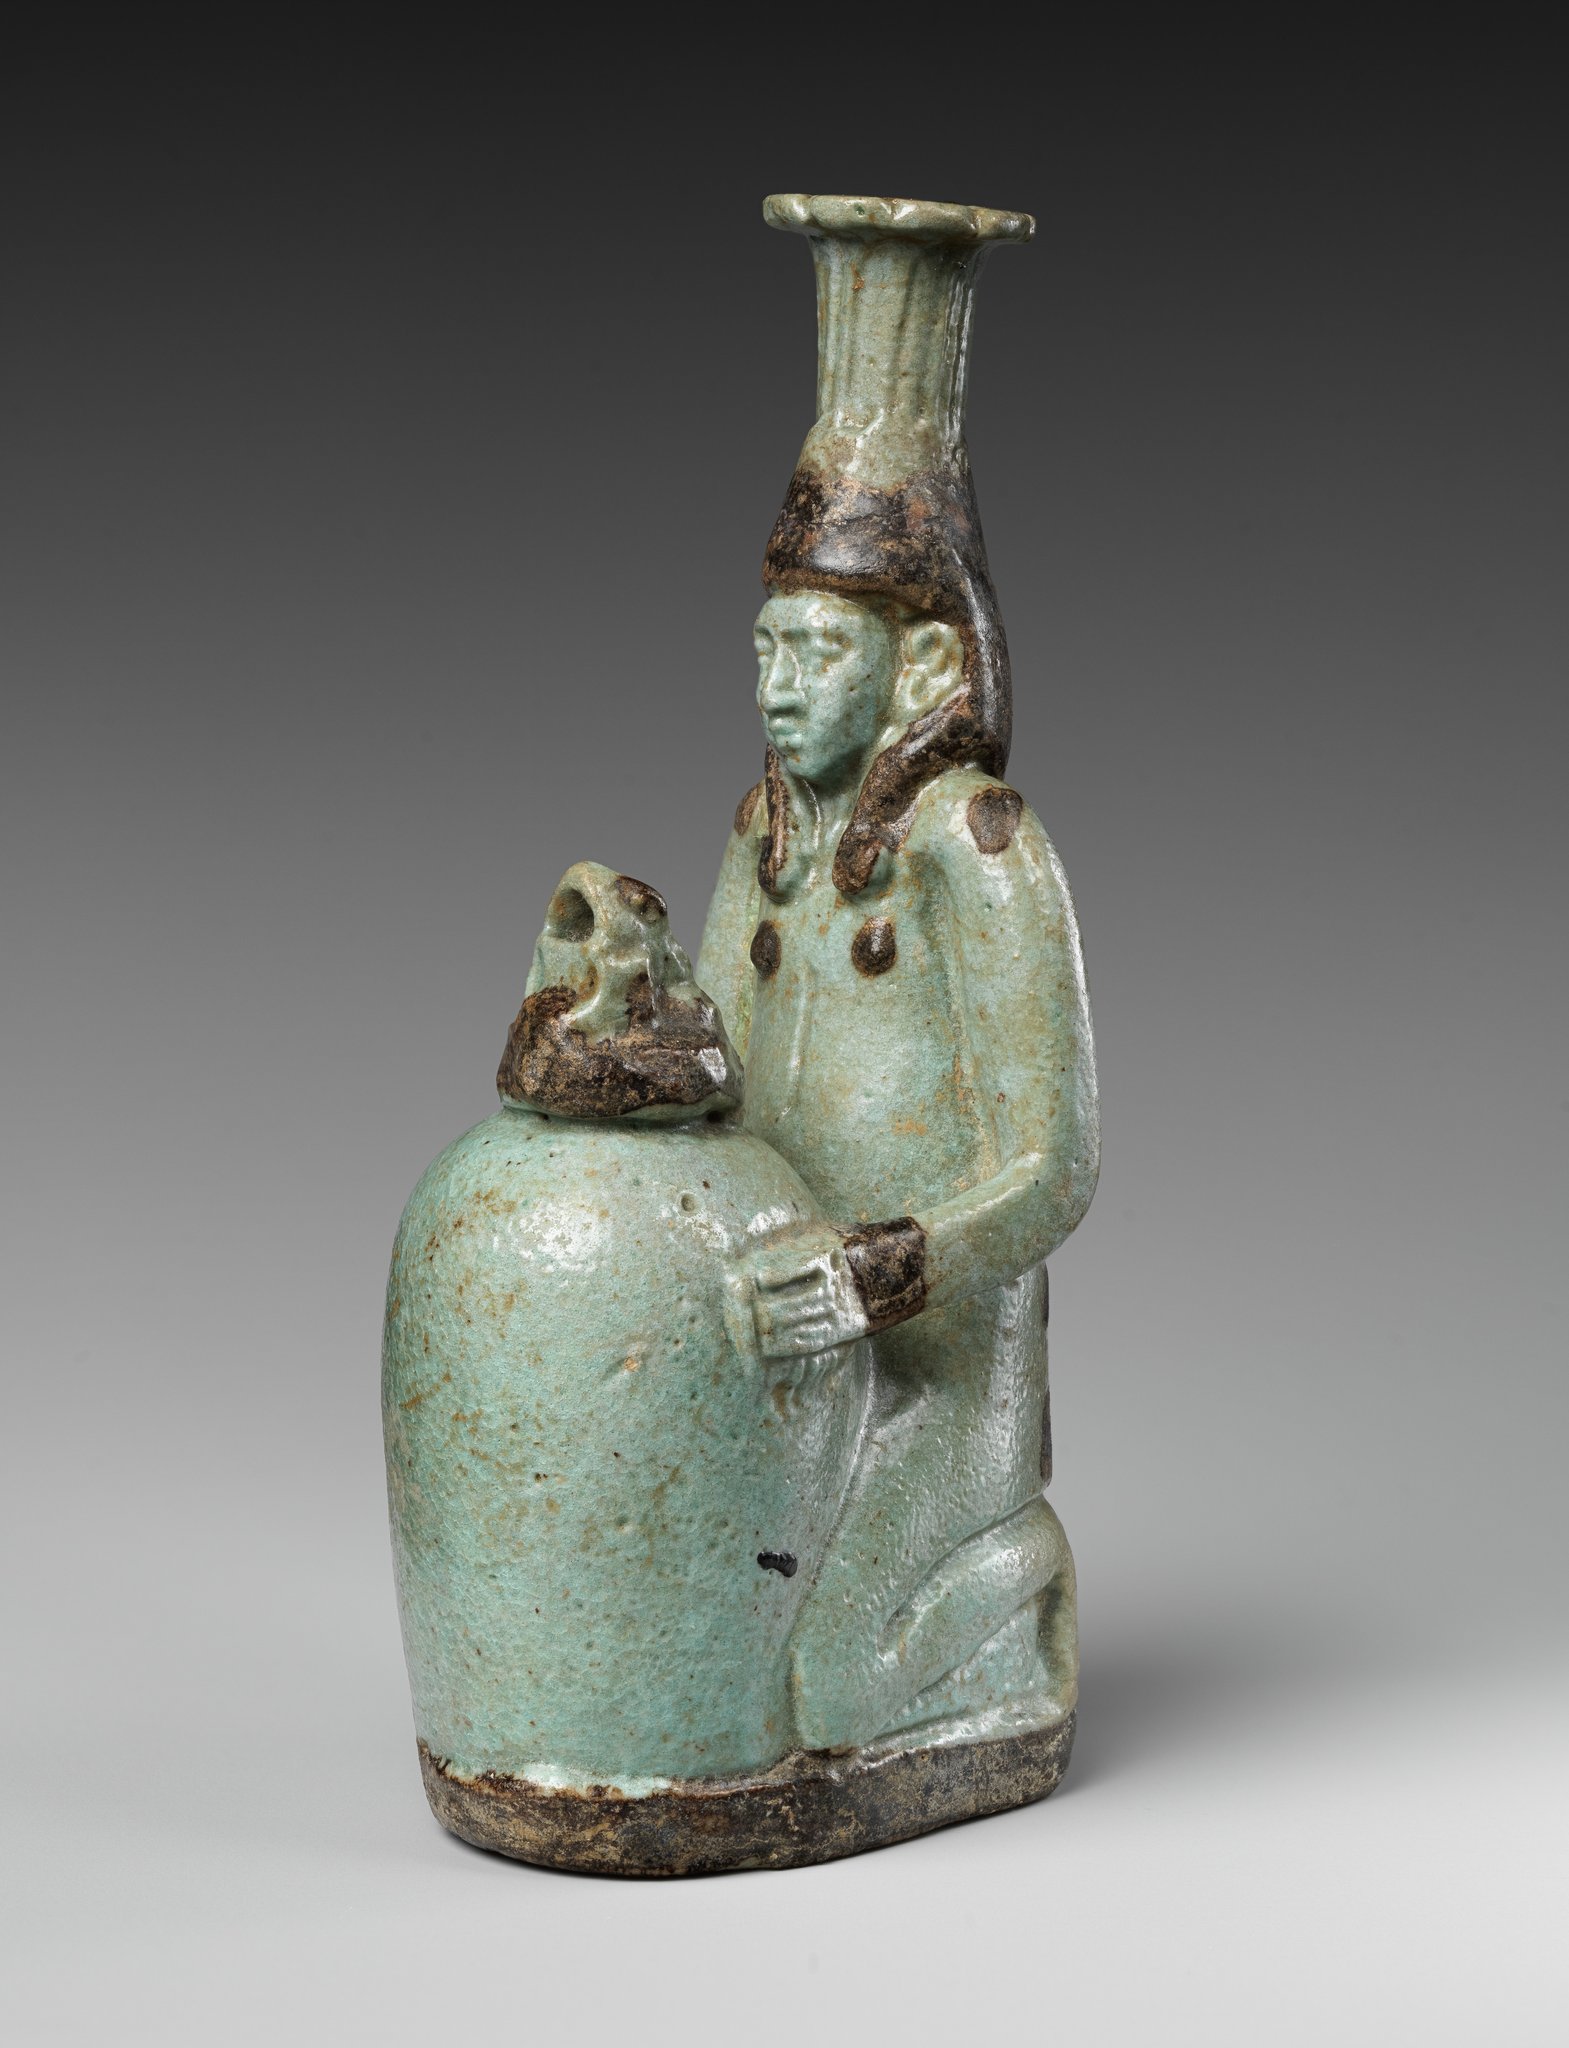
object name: vase in the form of a kneeling figure holding a jar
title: Faience double-spouted vessel in the form of a kneeling woman holding a jar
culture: east greek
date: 634-568 BCE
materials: faience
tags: women,jars